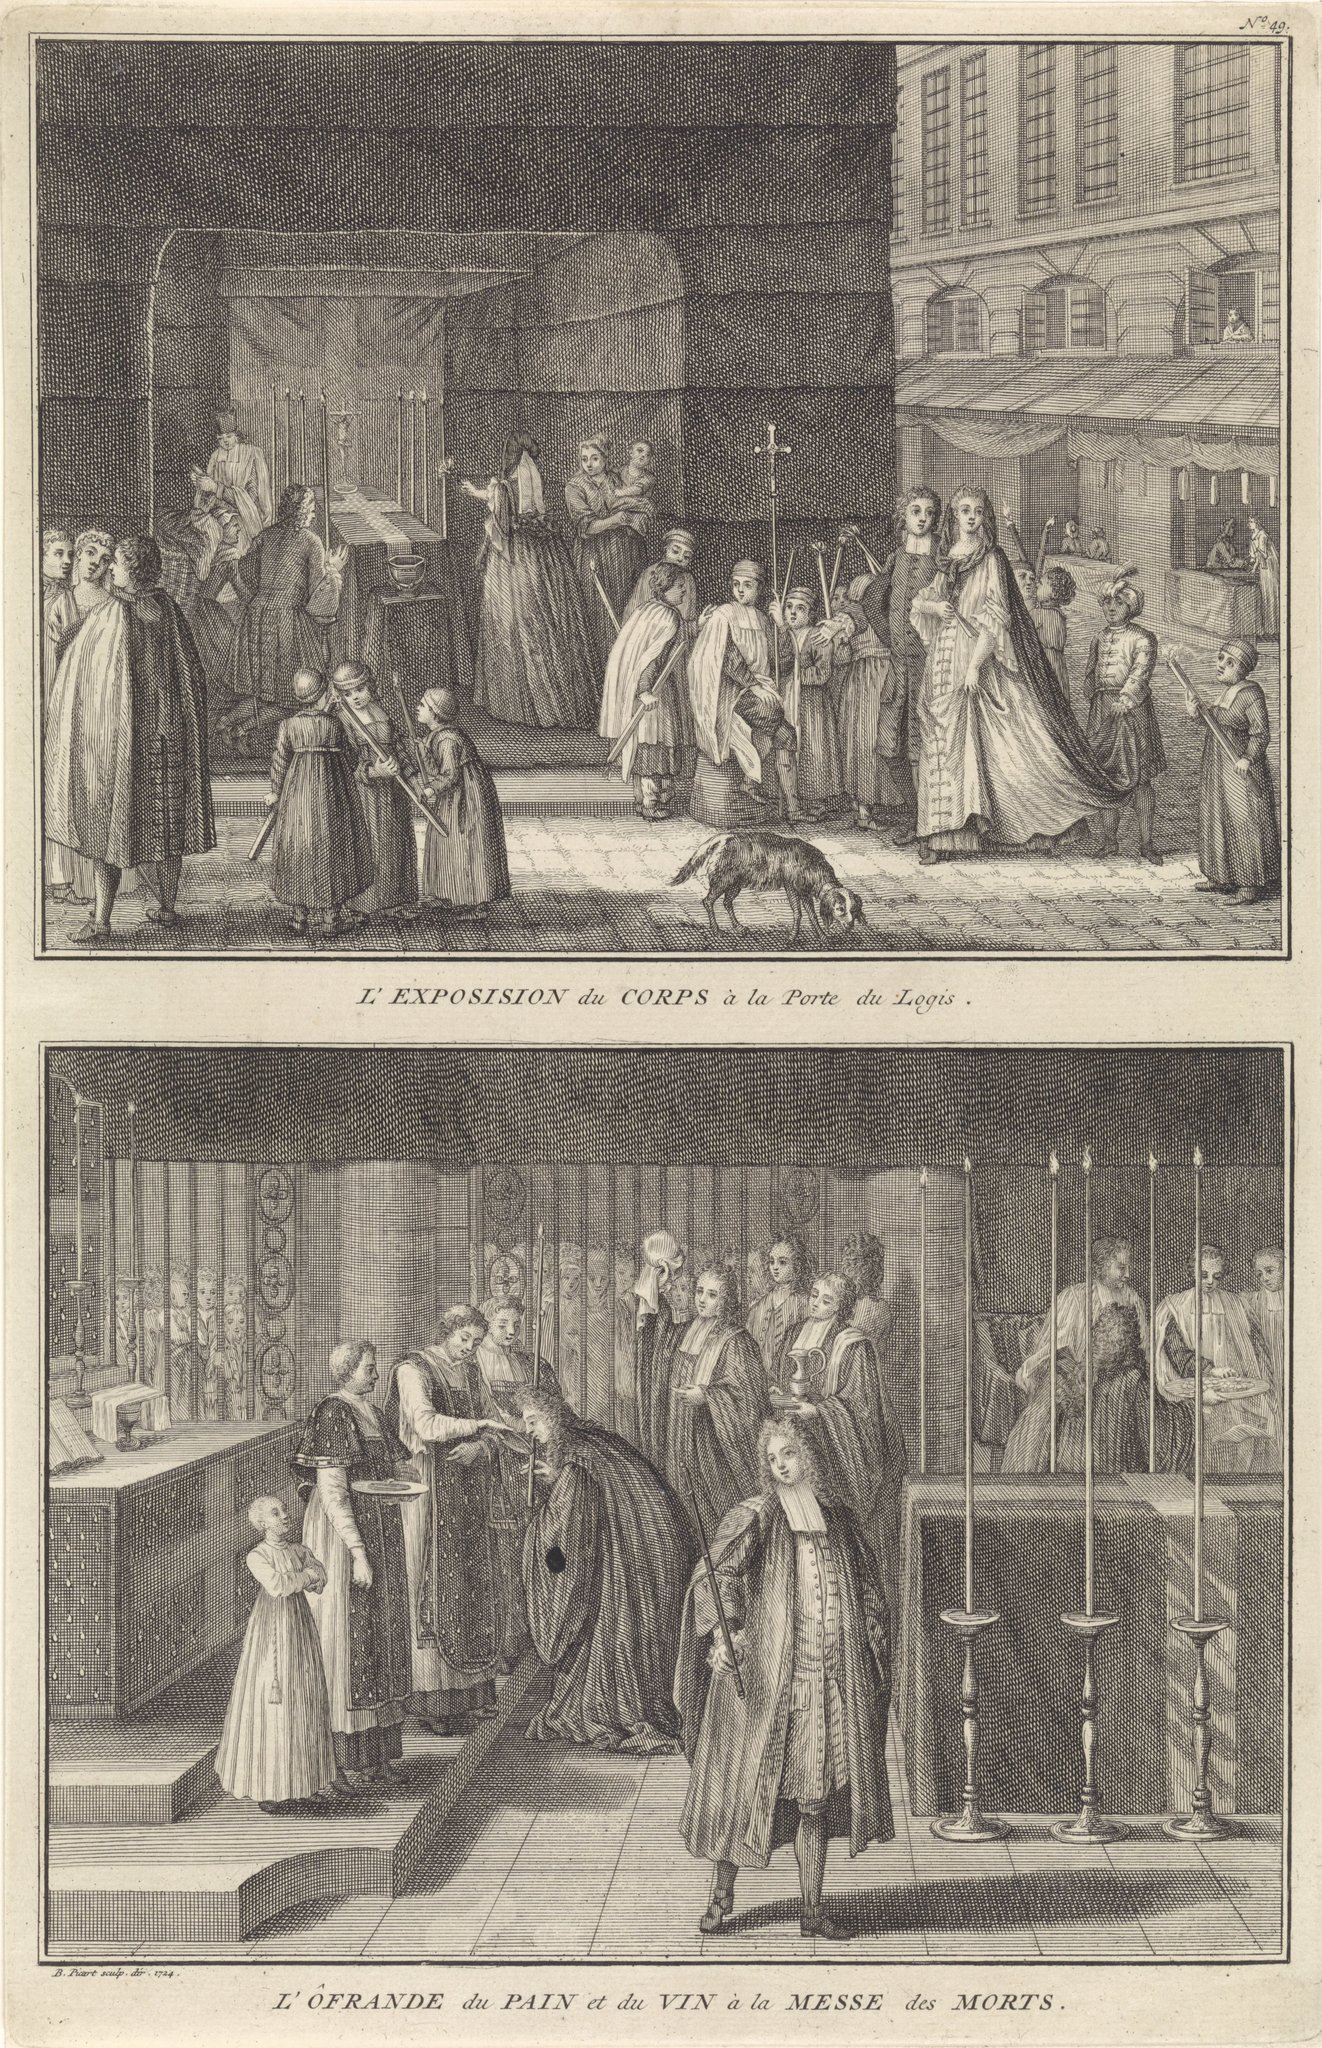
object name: print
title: L'Exposition du Corps à la Porte du Logis (...)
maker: bernard picart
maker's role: draughtsman, print maker, publisher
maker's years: 1673-1733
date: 1724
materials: paper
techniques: engraving, etching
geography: amsterdam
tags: vigils and wakes ~ burial rites, holy mass (divine service, especially of roman catholic church)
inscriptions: collector's mark: Lugt 2233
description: Prent gebruikt in en mogelijk gebruikt in andere edities van: Picart, Bernard. Ceremonies et coutumes religieuses de tous les peuples du monde (...). Tome second. Qui contient la suite des ceremonies religieuses en usage chez les catholiques. Deel 2. Amsterdam: Jean Frederic Bernard, 1723, na p. 98.